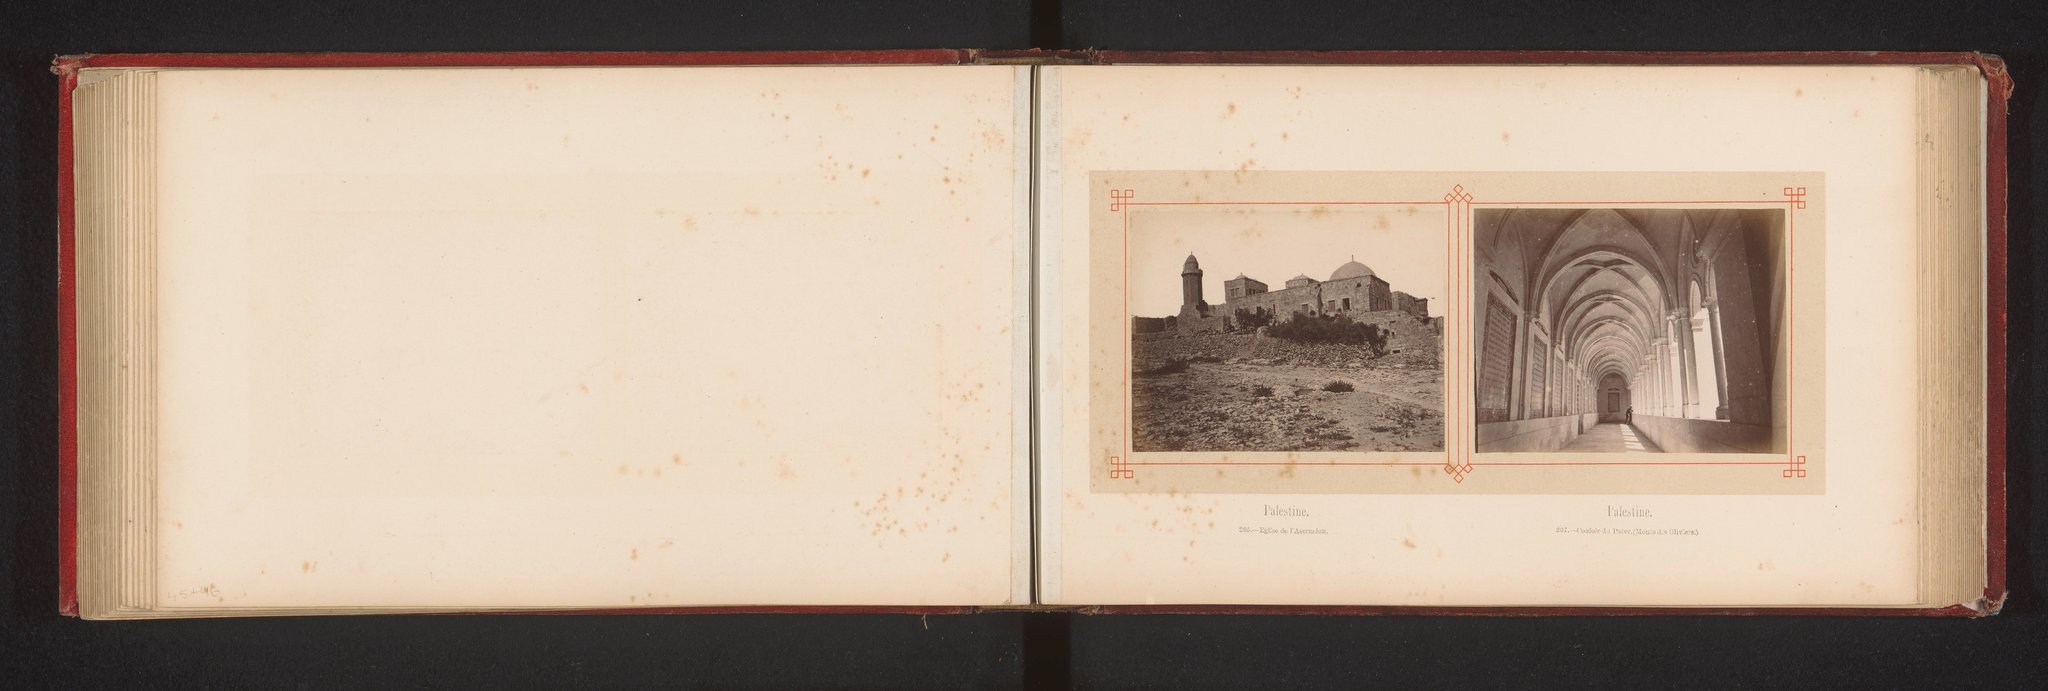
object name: page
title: Gezicht op een hal met zuilen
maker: félix bonfils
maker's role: fotograaf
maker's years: 1831-1885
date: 1873-1878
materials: photographic support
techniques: albumen print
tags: column, pillar ~ architecture